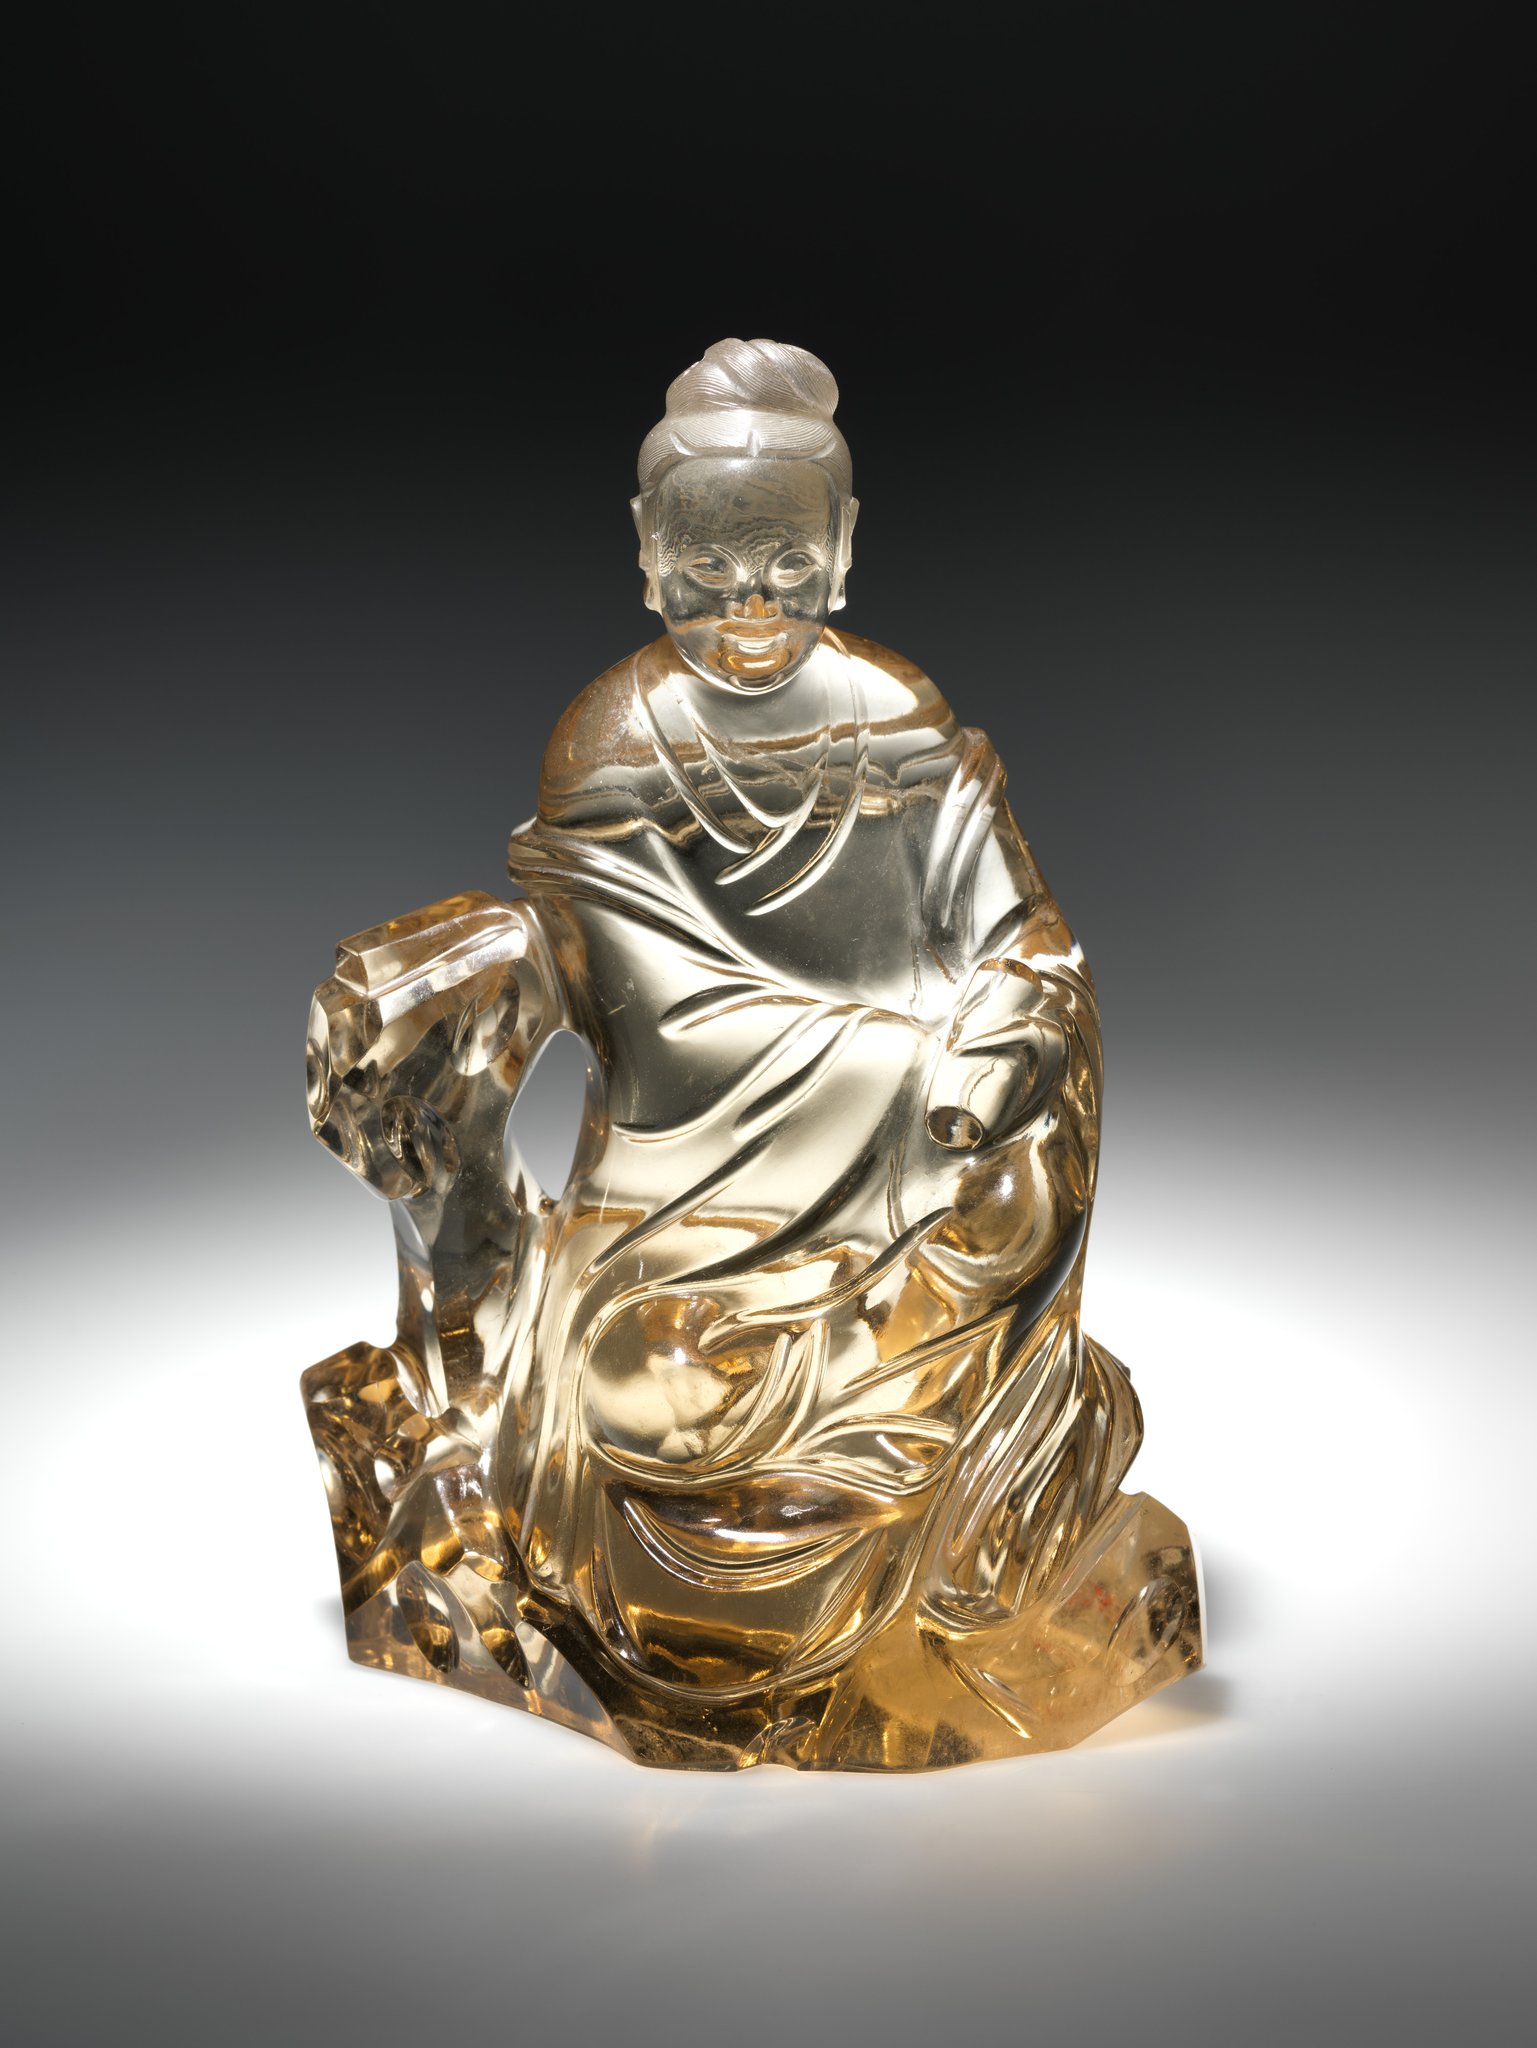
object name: figure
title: Bodhisattva Guanyin seated on a rock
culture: chinese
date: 1701-1800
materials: crystal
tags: buddhism,bodhisattvas